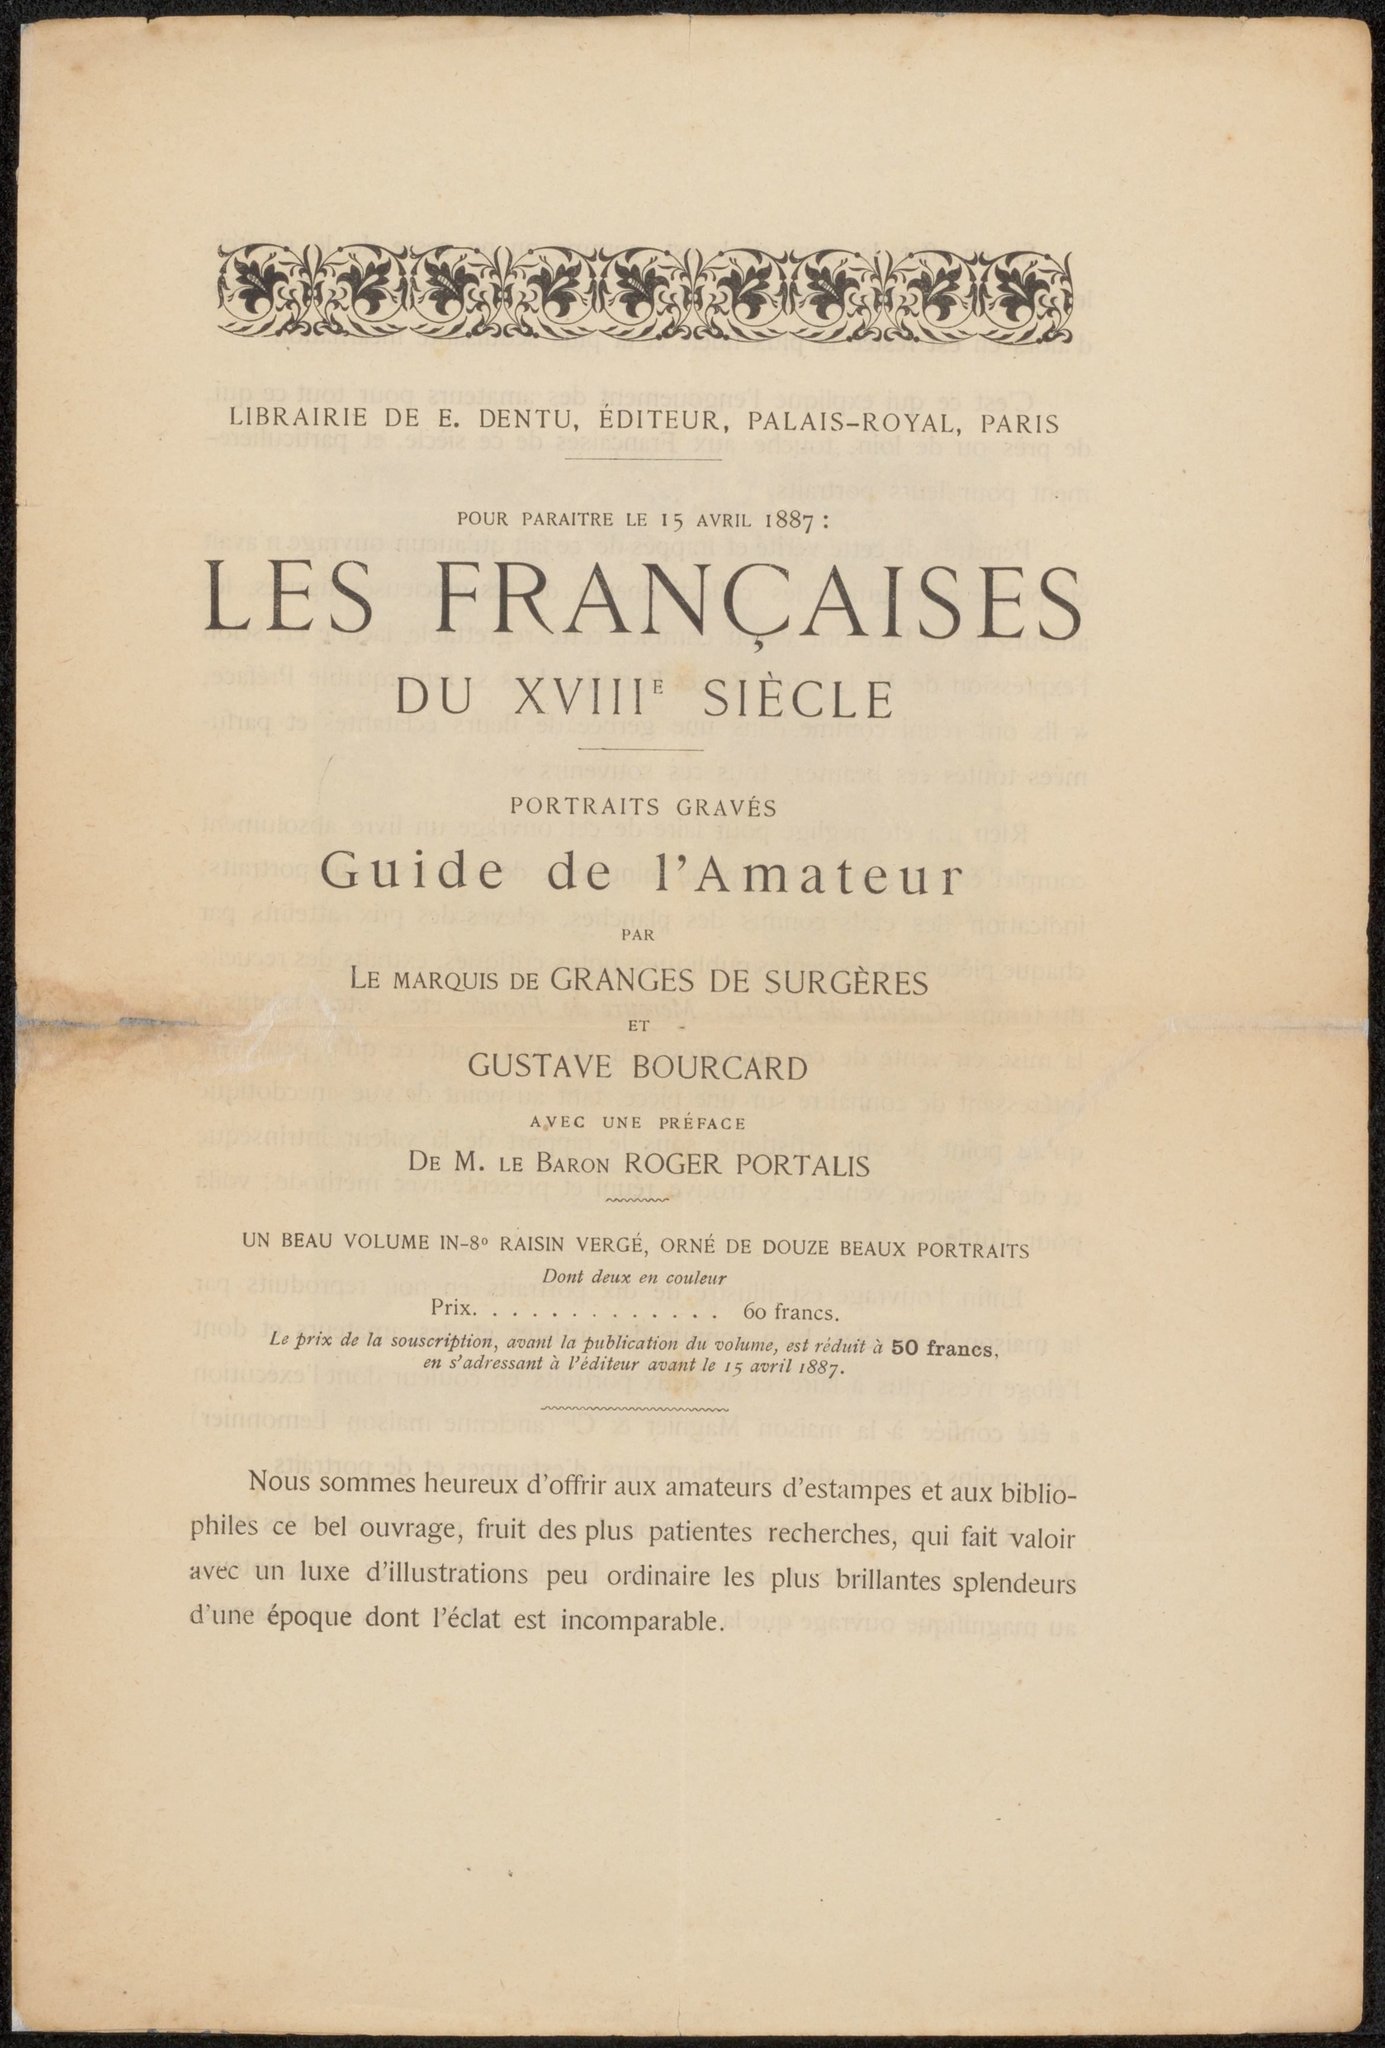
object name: tekst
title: Tekst met aankondiging van publicatie 'Les Françaises du XVIIIe Siècle' uit archief Philip Zilcken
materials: paper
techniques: printing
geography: paris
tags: gustave bourcard, the hague, painter, draughtsman, philip zilcken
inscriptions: collector's mark: ‘RPK’